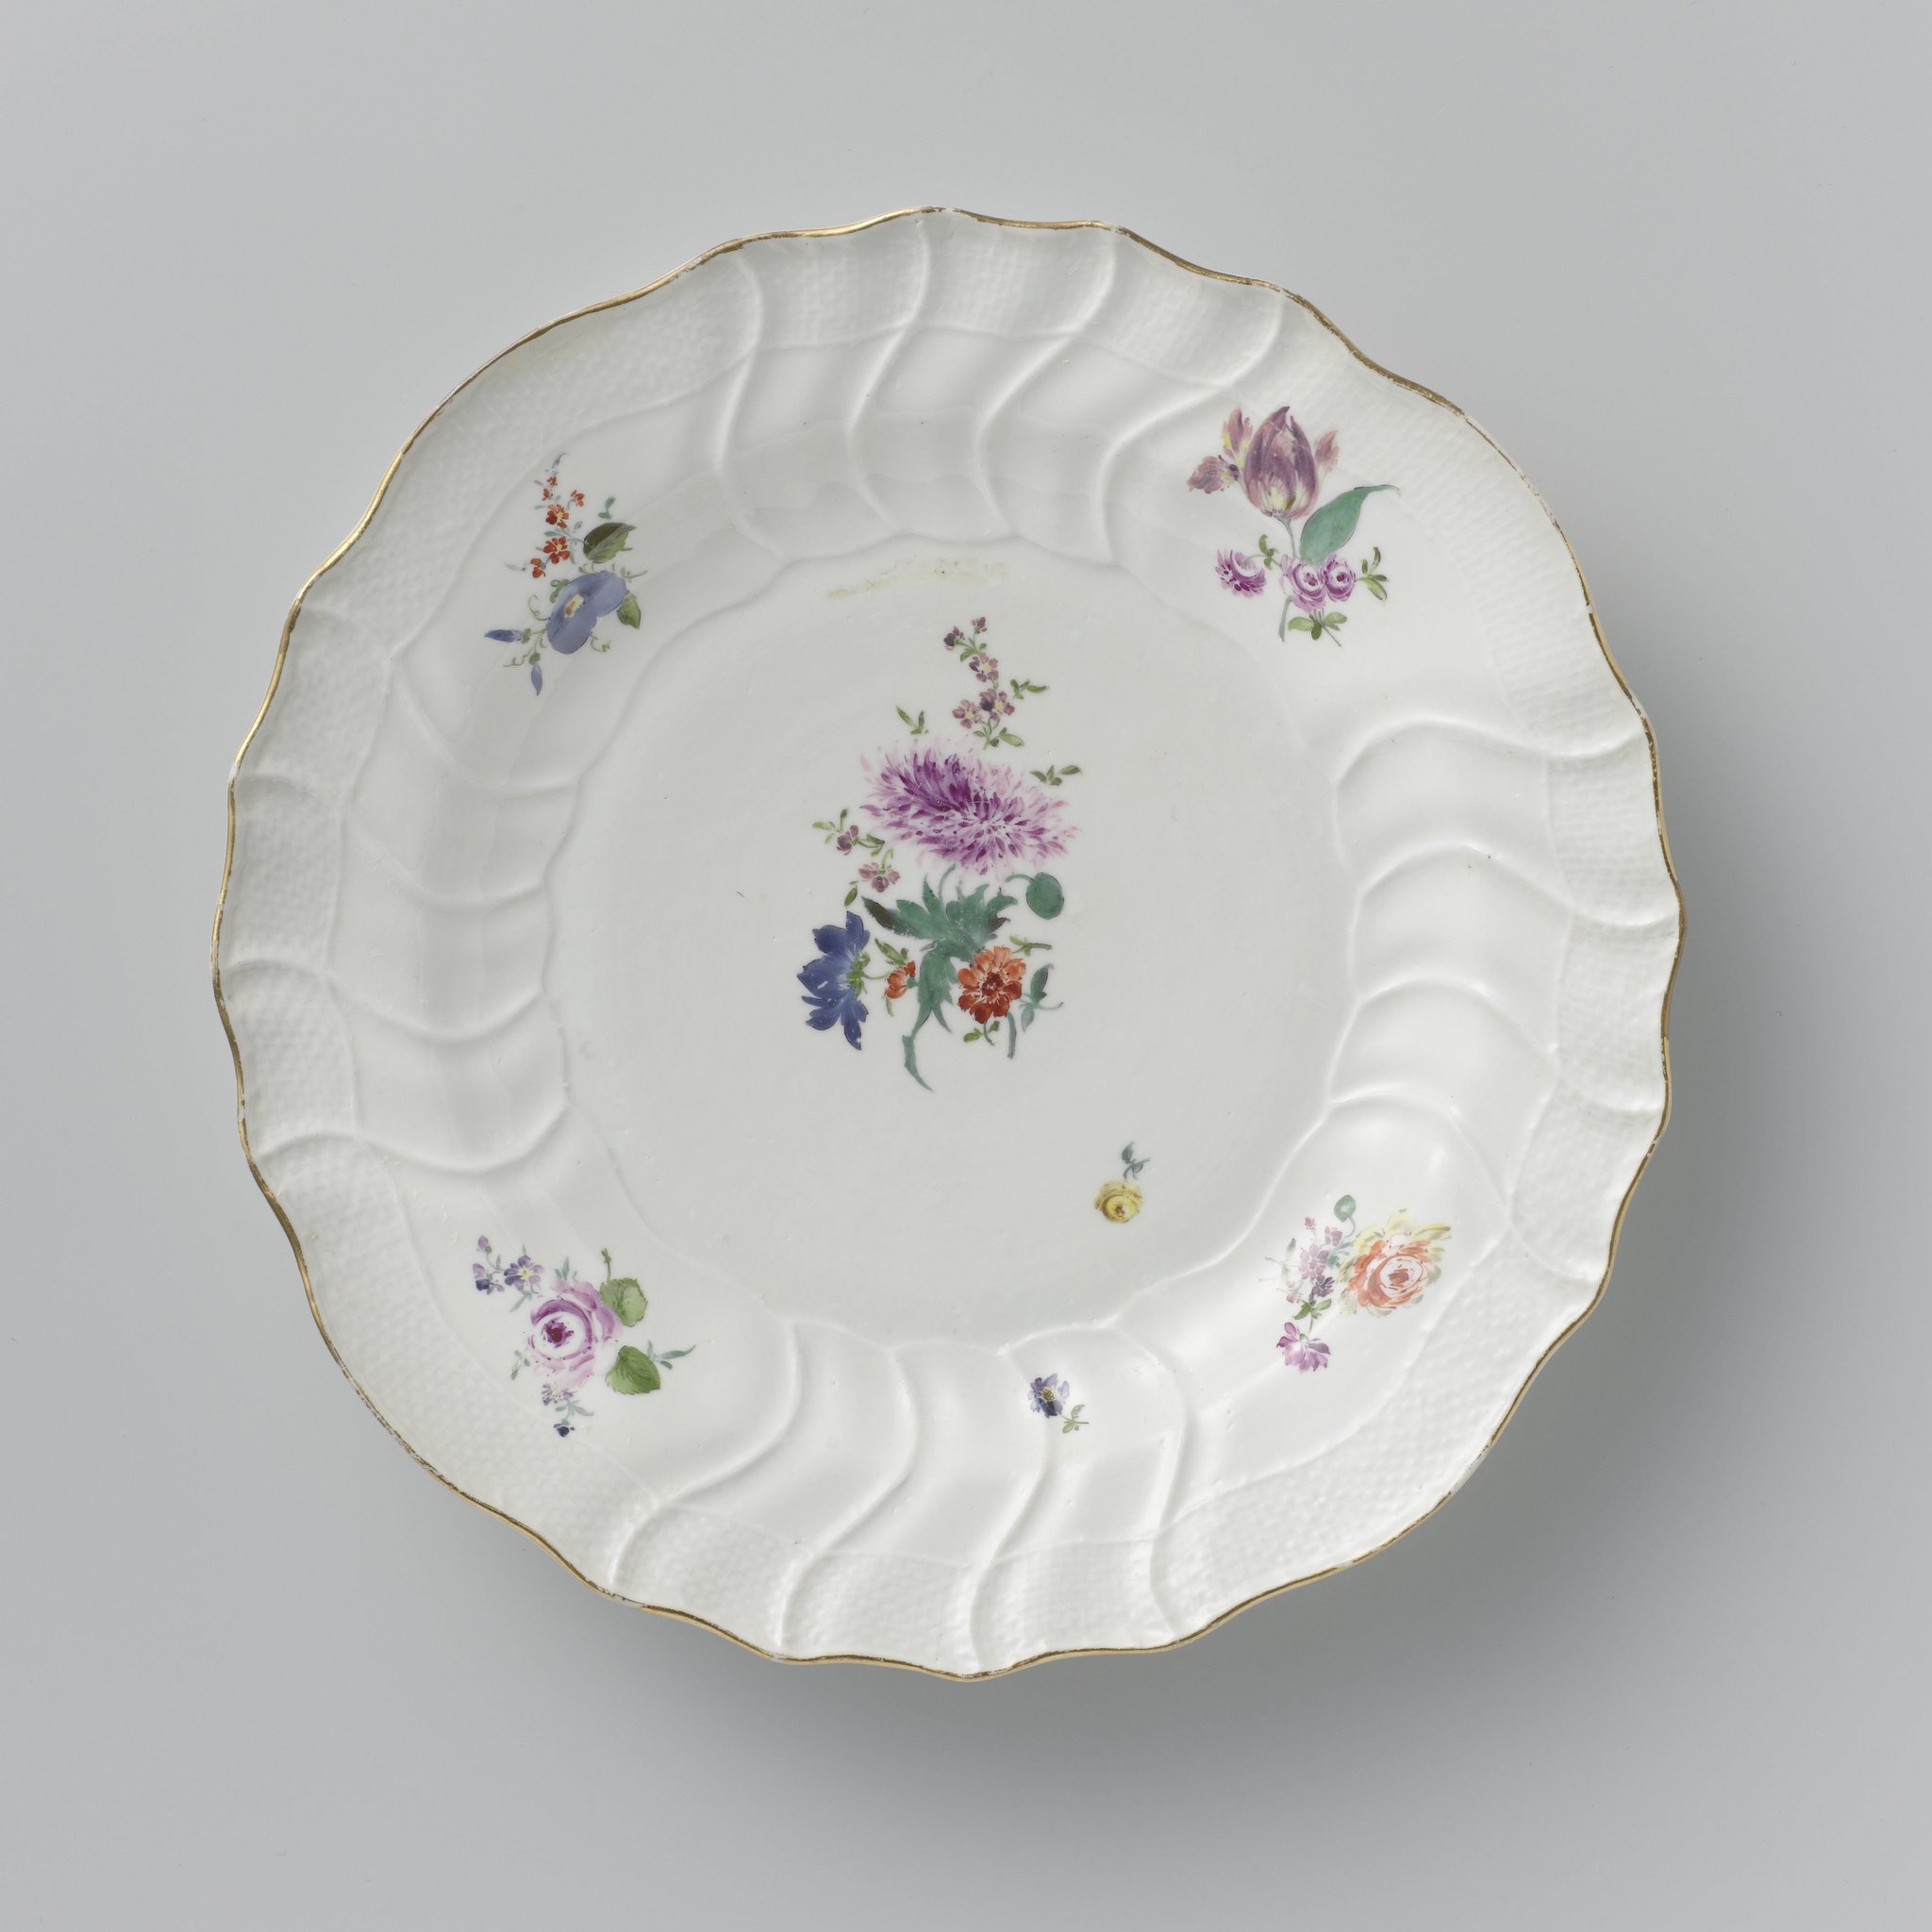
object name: eating drinking utensil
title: Bord, veelkleurig beschilderd met Deutsche Blumen, insekten en vruchten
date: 1750-1760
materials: porcelain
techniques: painted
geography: meissen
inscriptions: factory mark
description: Rond bord van beschilderd porselein. Het bord is beschilderd met Deutsche Blumen, insekten en vruchten. De rand is in reliëf versierd met het Neuozier-patroon. Het bord is gemerkt en hoort bij een servies (BK-17474-1 t/m BK-17474-253).